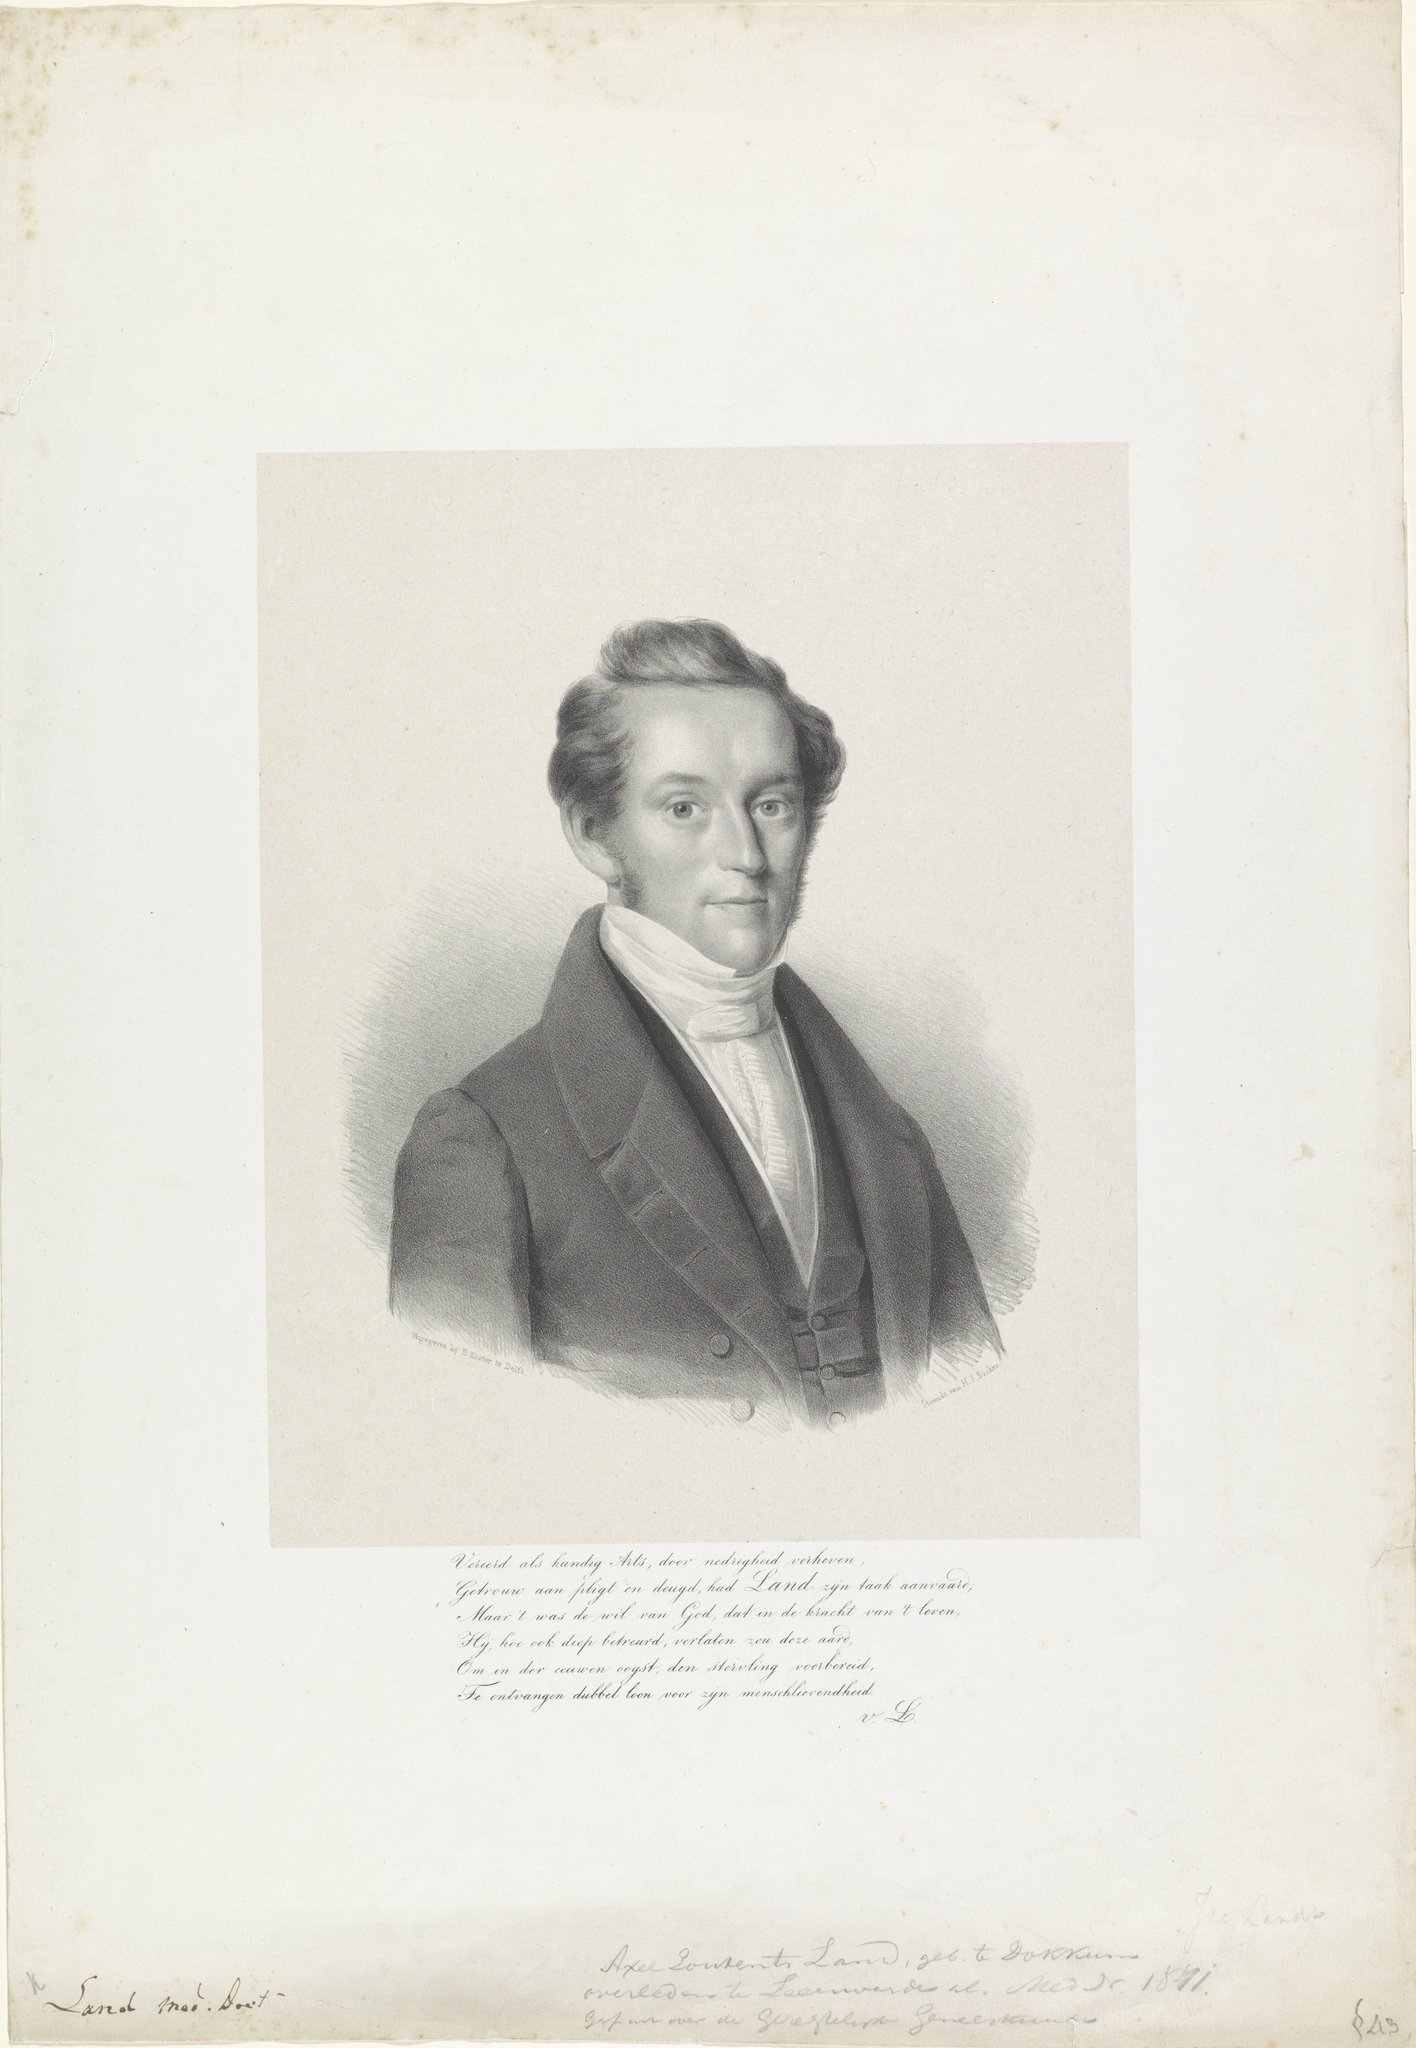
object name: print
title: Portret van Axel Lourents Land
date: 1822-1845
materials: paper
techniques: lithograph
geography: delft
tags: historical persons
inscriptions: collector's mark: Lugt 2228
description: Aan deze derde staat zijn de drukker, uitgever en enkele dichtregels toegevoegd.